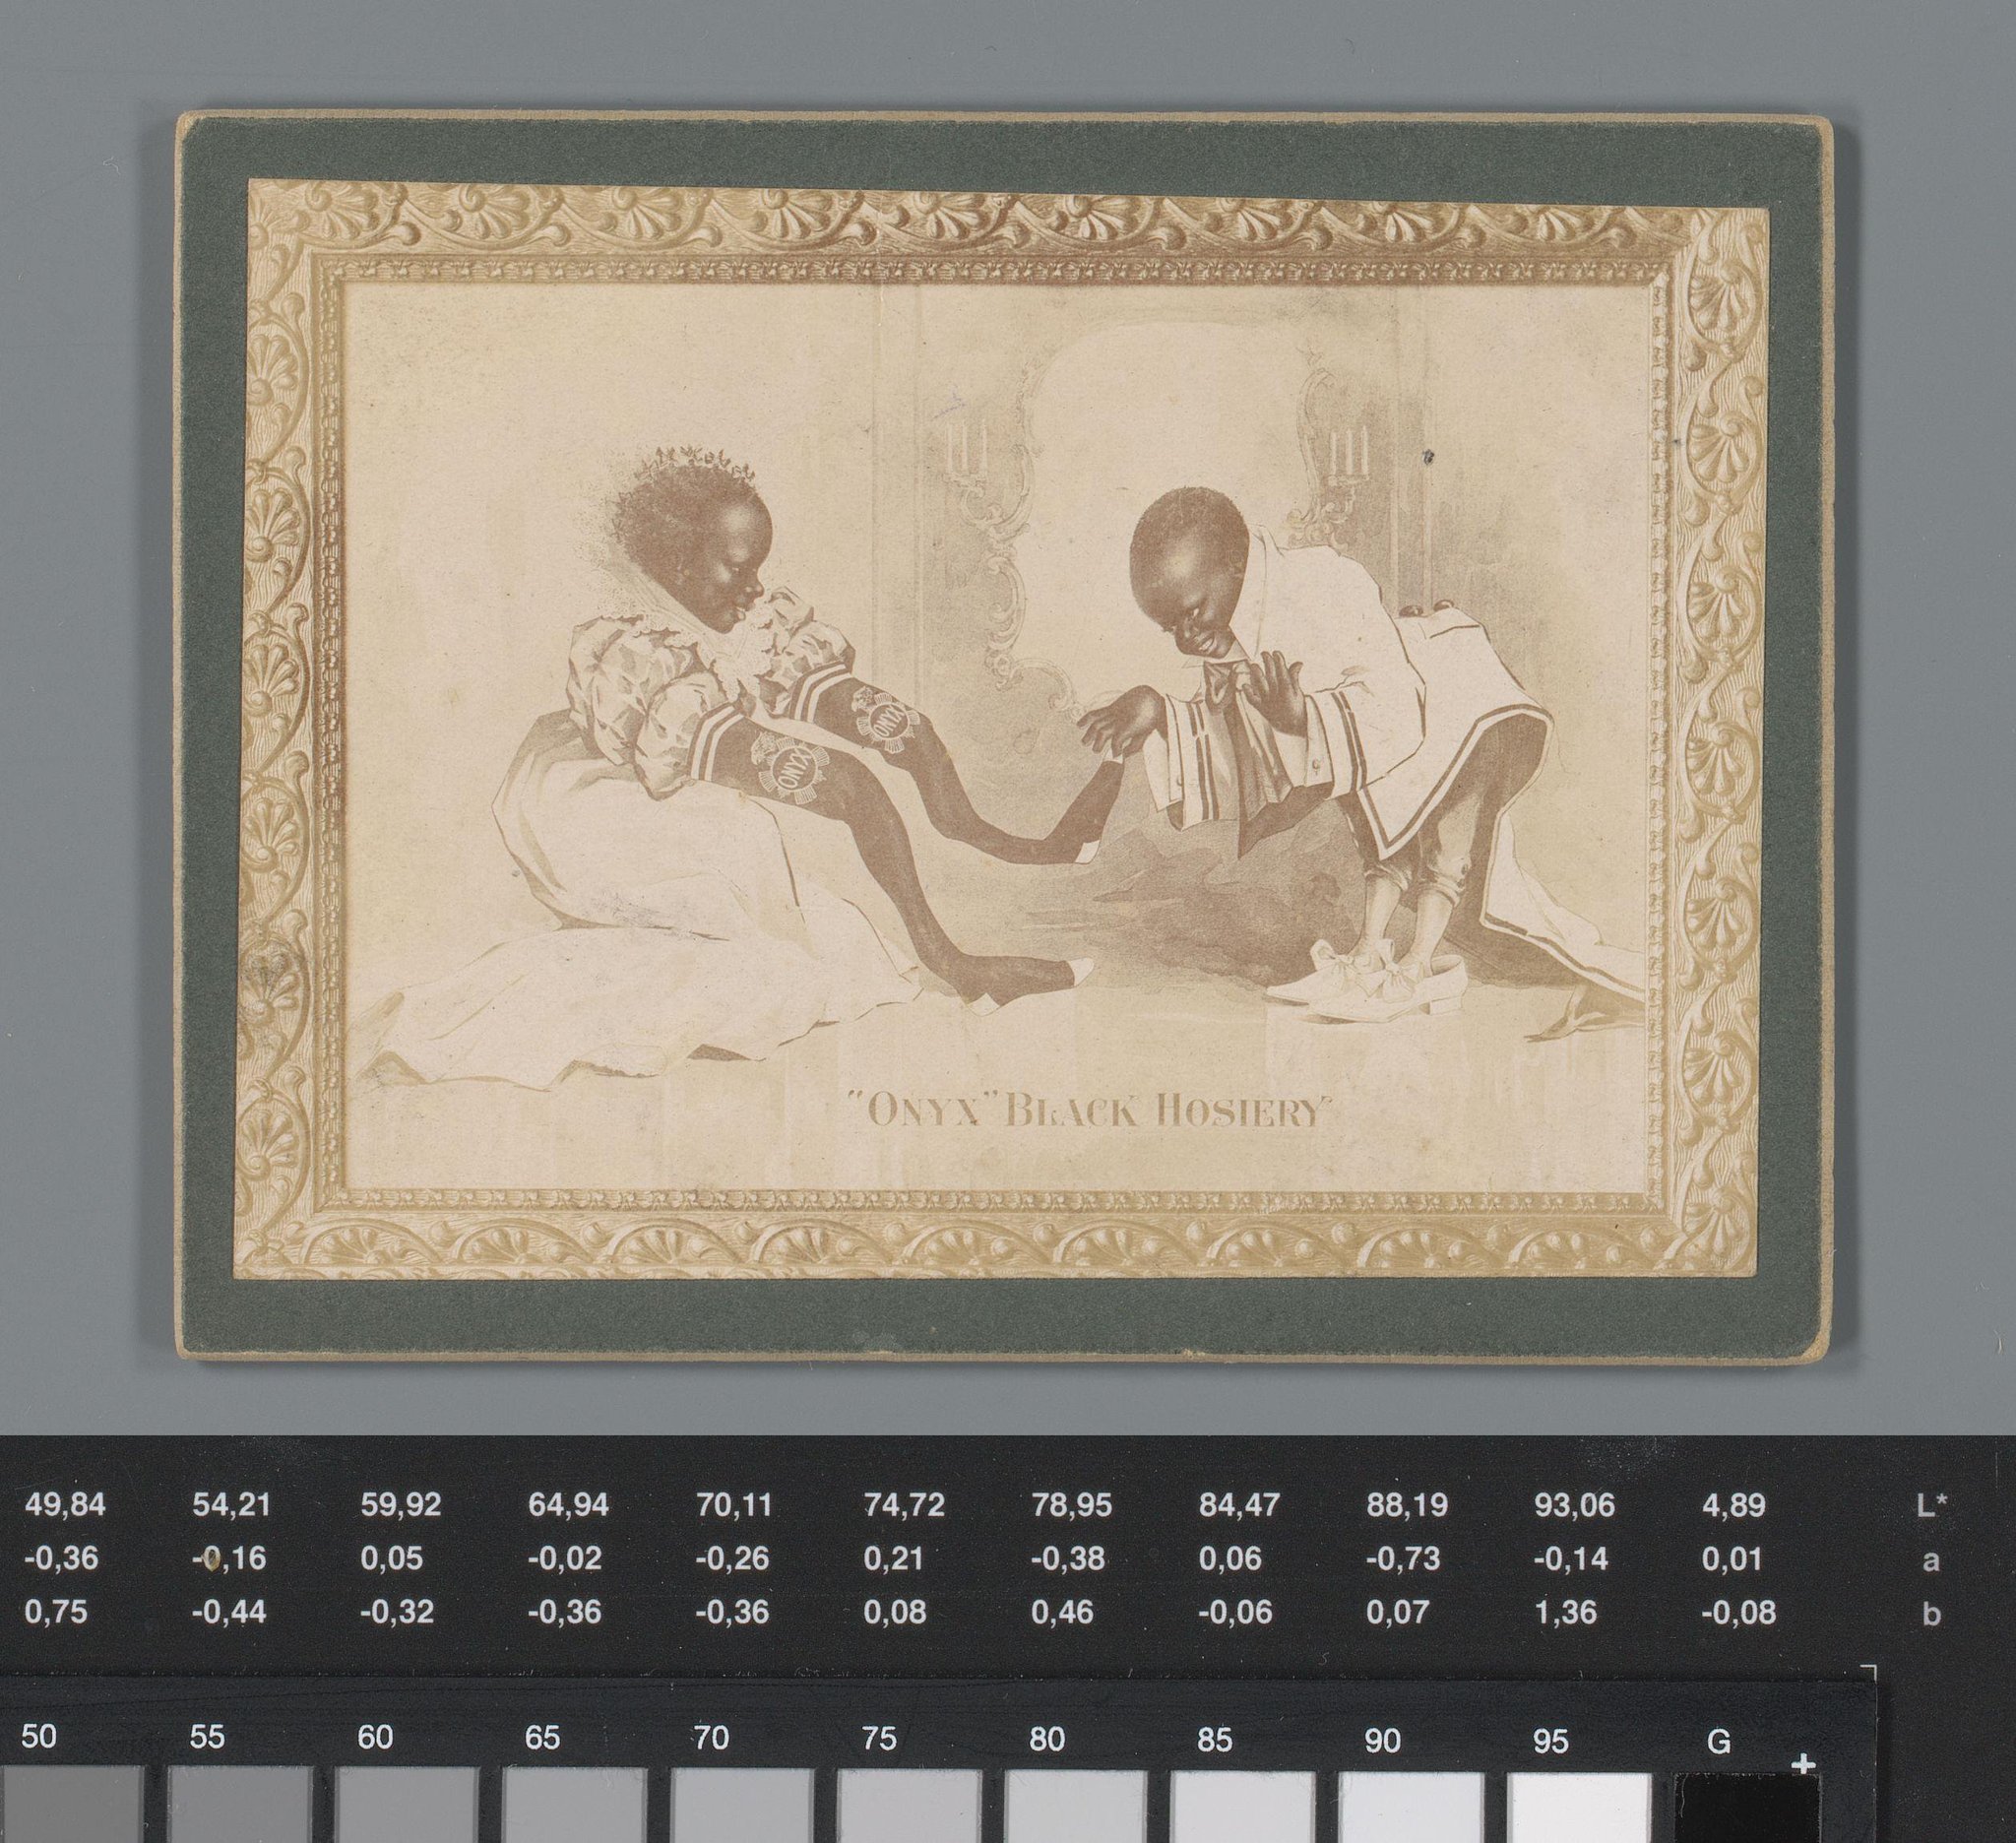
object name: reproduction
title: Reclame voor zwarte kousen van Onyx met reproductie van een racistische prent van twee spelende kinderen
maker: Anonymous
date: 1850-1915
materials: cardboard, photographic support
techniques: albumen print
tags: advertising, dress-up party, african peoples, africans (+ caricatured), trade games, imitative games, imitating adults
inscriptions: inscription: ‘"ONYX" BLACK HOSIERY’